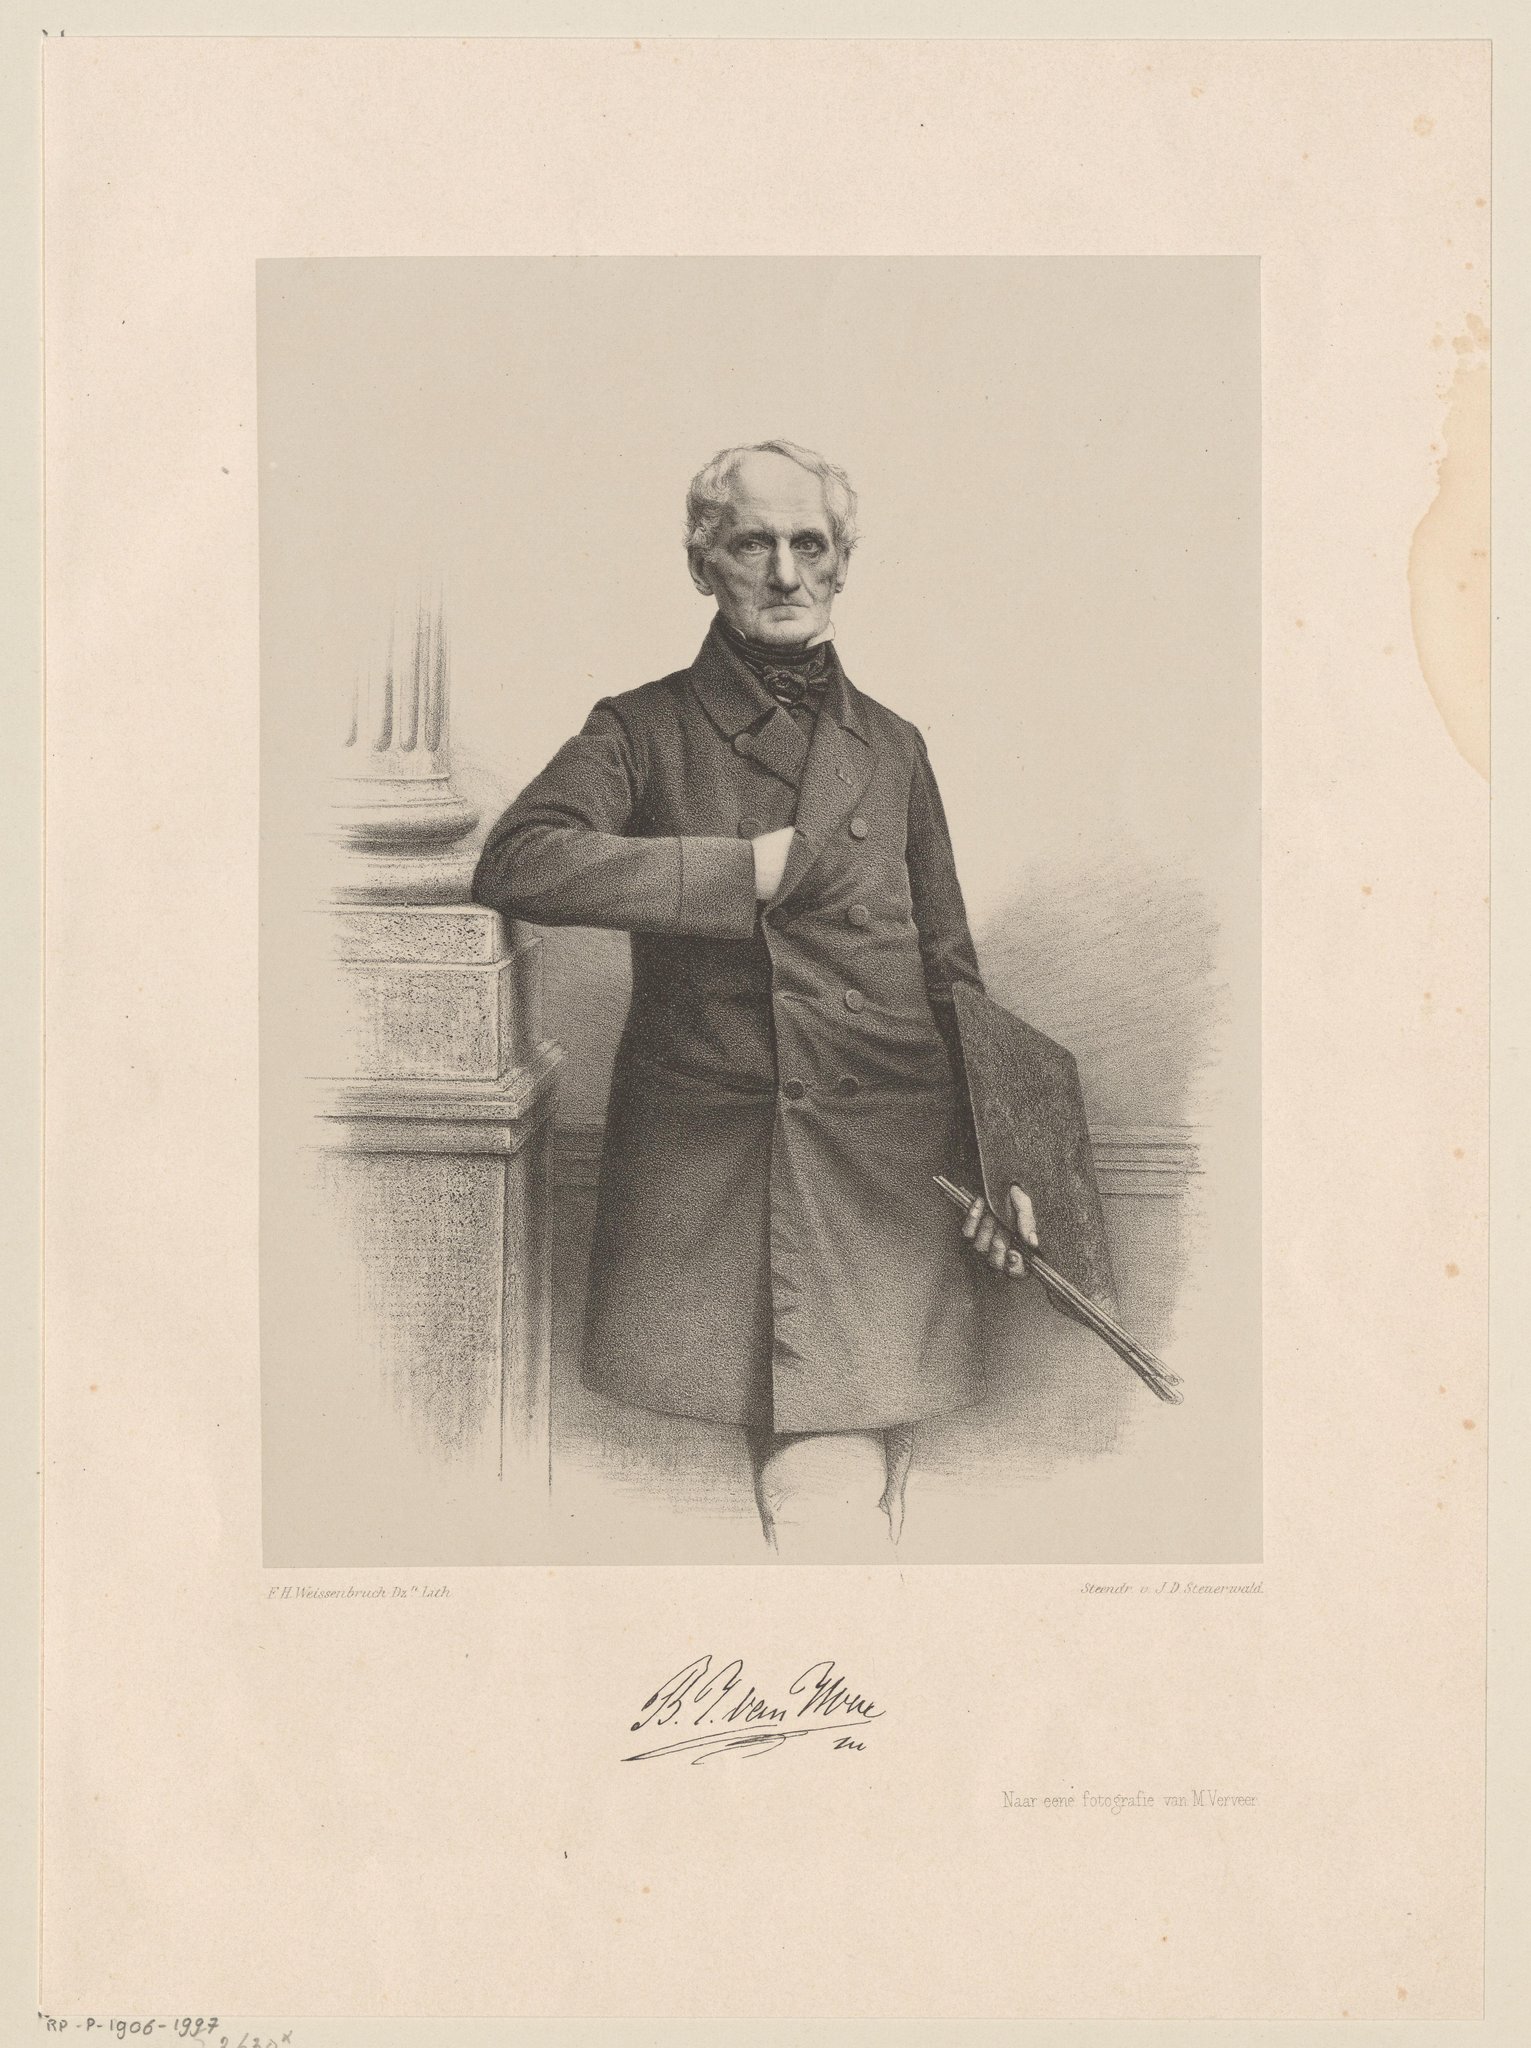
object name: print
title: Portret van Bartholomeus Johannes van Hove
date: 1850-1863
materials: paper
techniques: lithograph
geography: the hague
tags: the hague, painter, print maker, draughtsman, bartholomeus johannes van hove, historical persons, portrait, self-portrait of painter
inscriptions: collector's mark: Lugt 2228